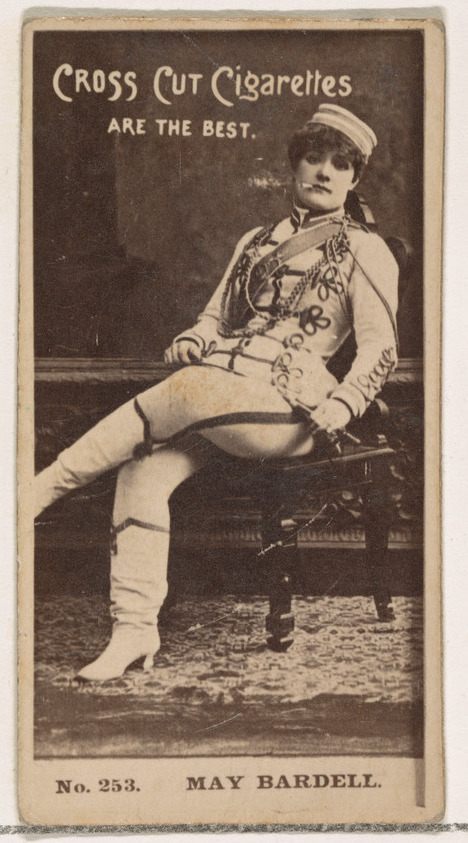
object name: print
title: Card Number 253, May Bardell, from the Actors and Actresses series (N145-2) issued by Duke Sons & Co. to promote Cross Cut Cigarettes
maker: w. duke, sons & co.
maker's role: publisher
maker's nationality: american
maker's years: 1870-1920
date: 1880-1889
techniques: albumen silver print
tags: portraits,women,smoking,actresses